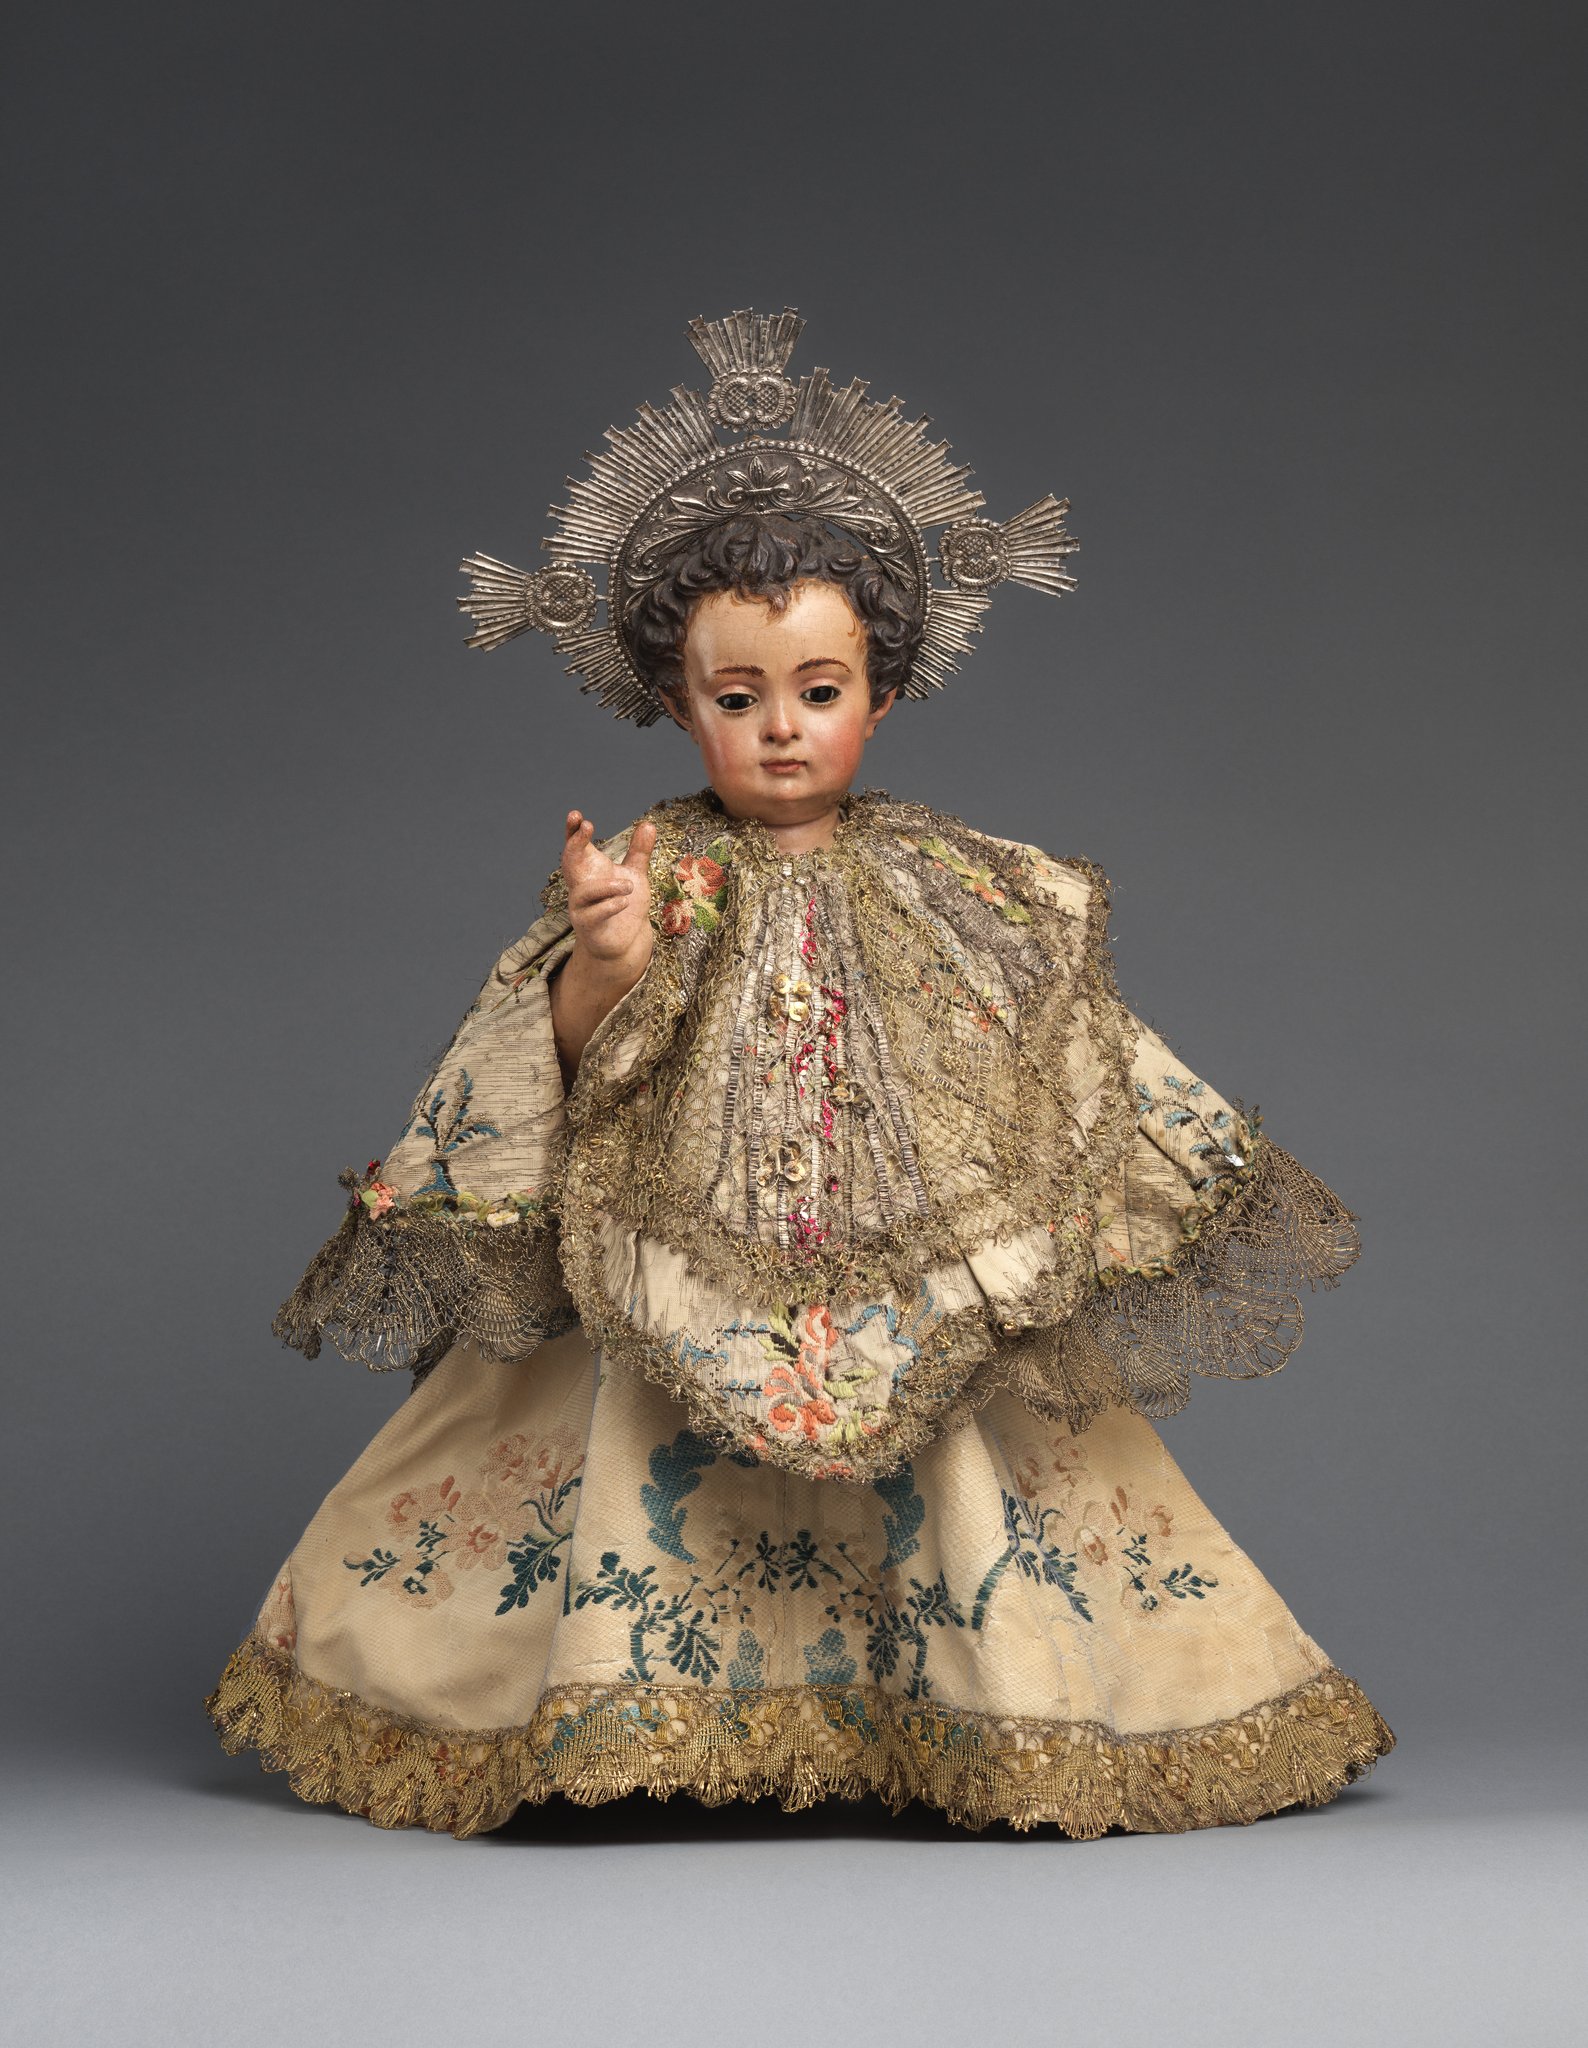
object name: dress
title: Dress for a statuette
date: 1701-1800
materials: glass, lace, lead, silk, silver, silver gilt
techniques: polychrome